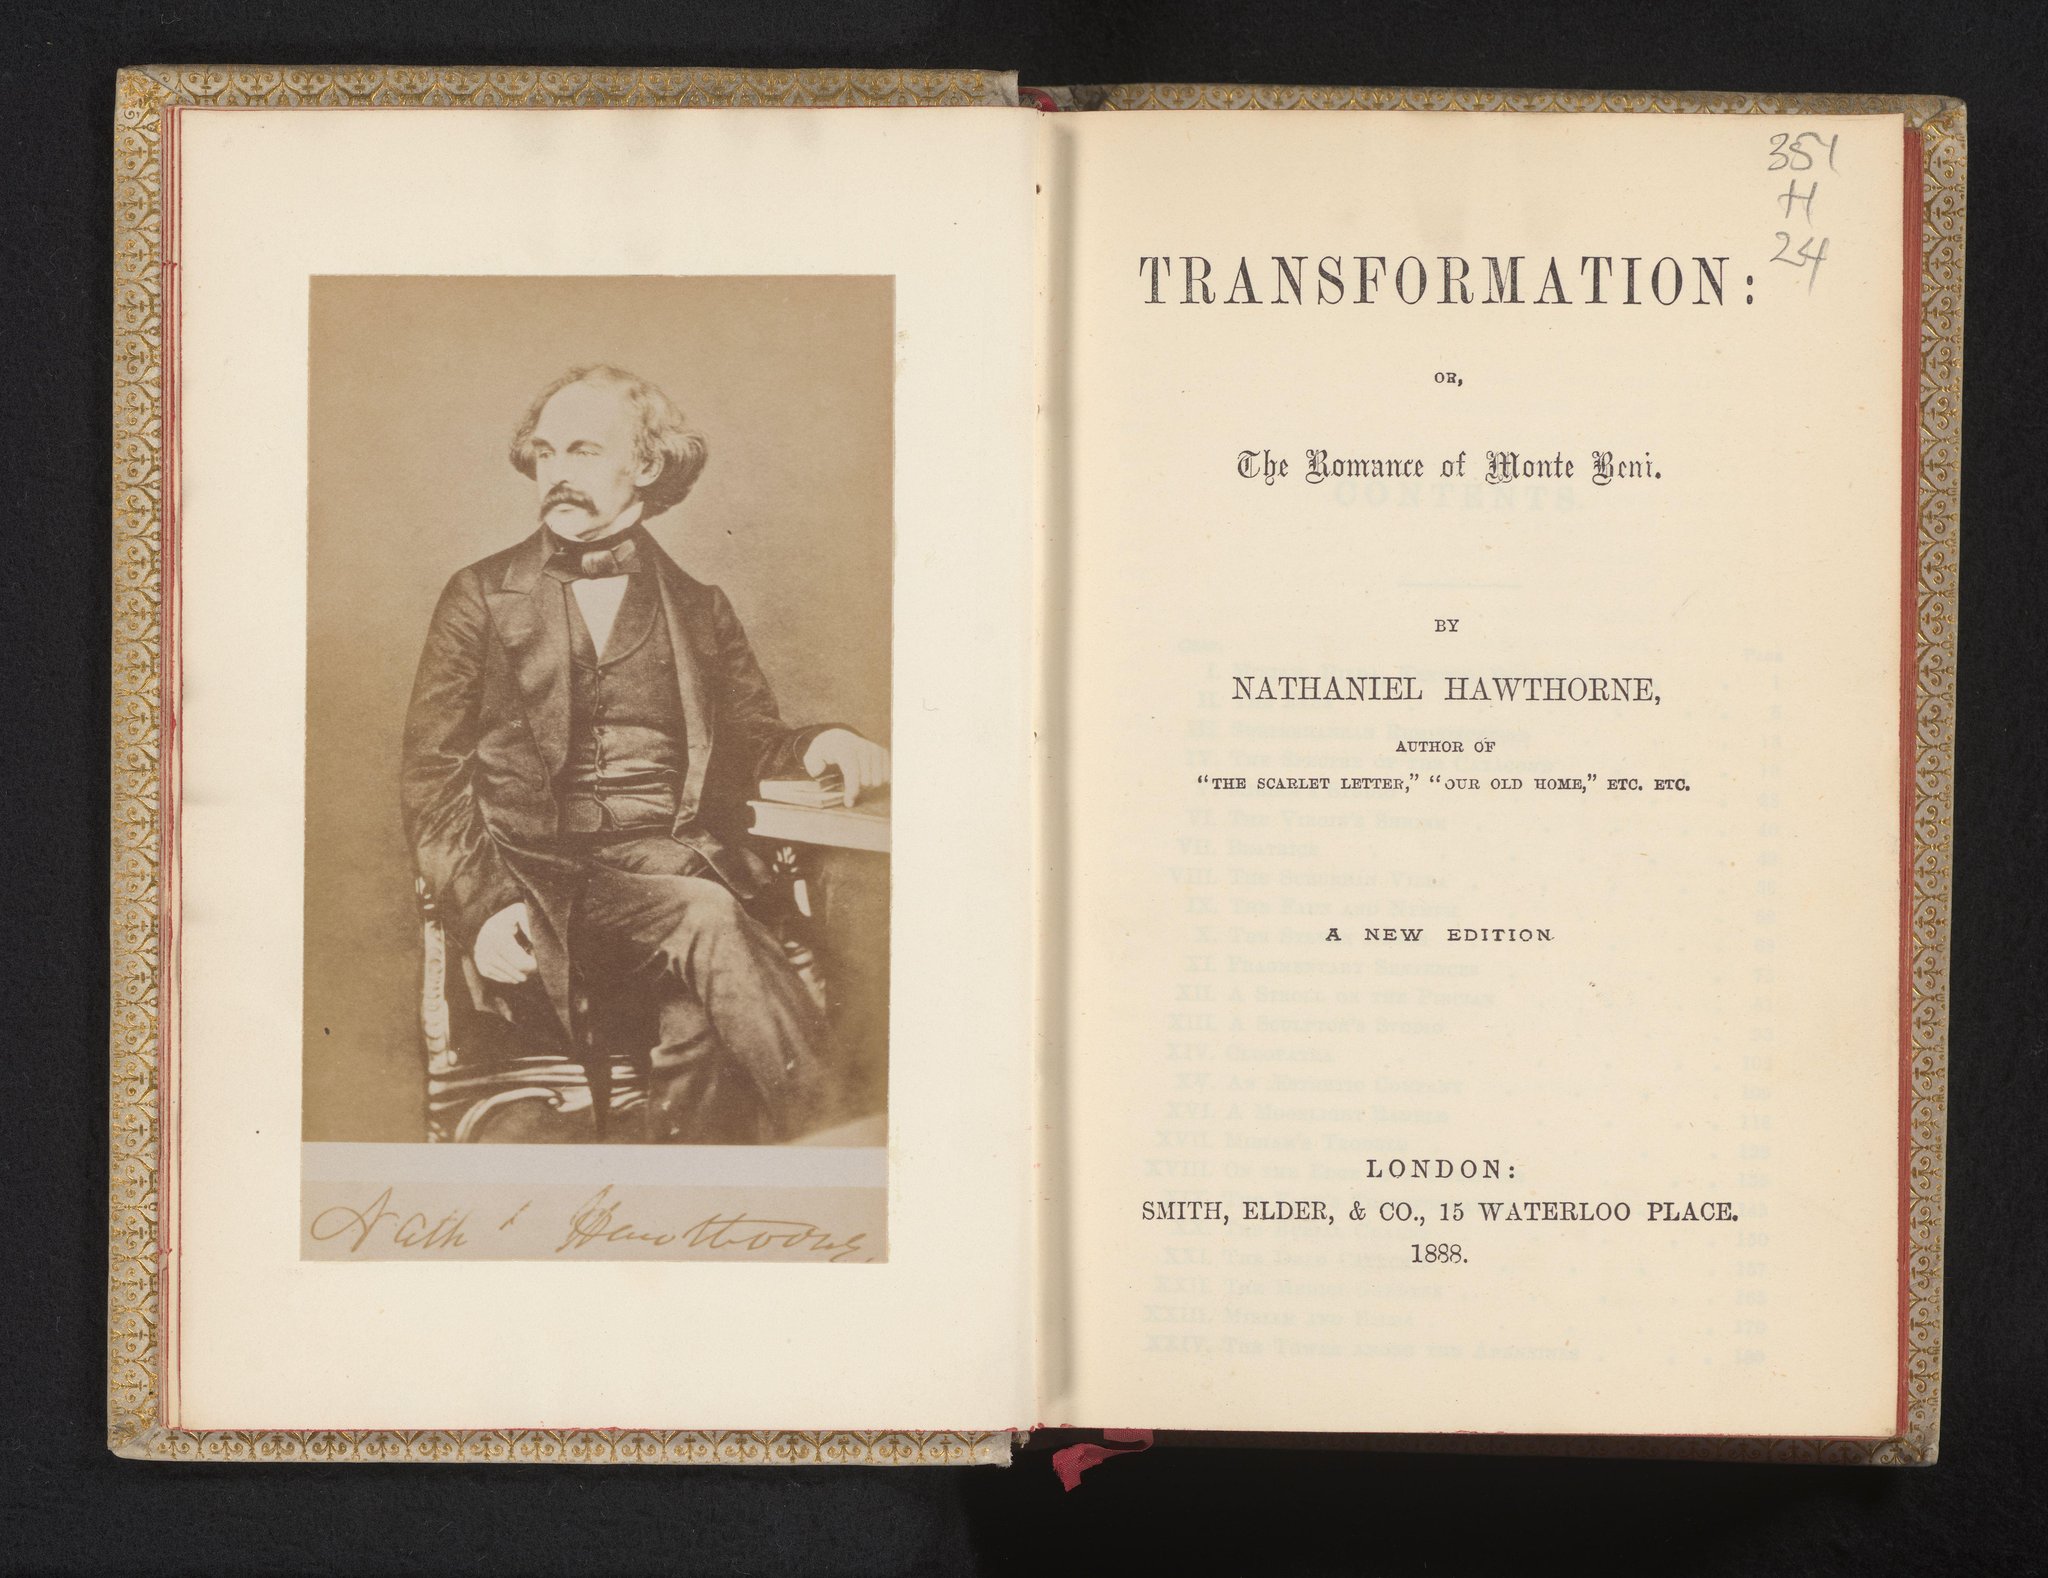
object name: page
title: Portret van Nathaniel Hawthorne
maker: Anonymous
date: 1883-1888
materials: paper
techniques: albumen print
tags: nathaniel hawthorne, portrait of a writer